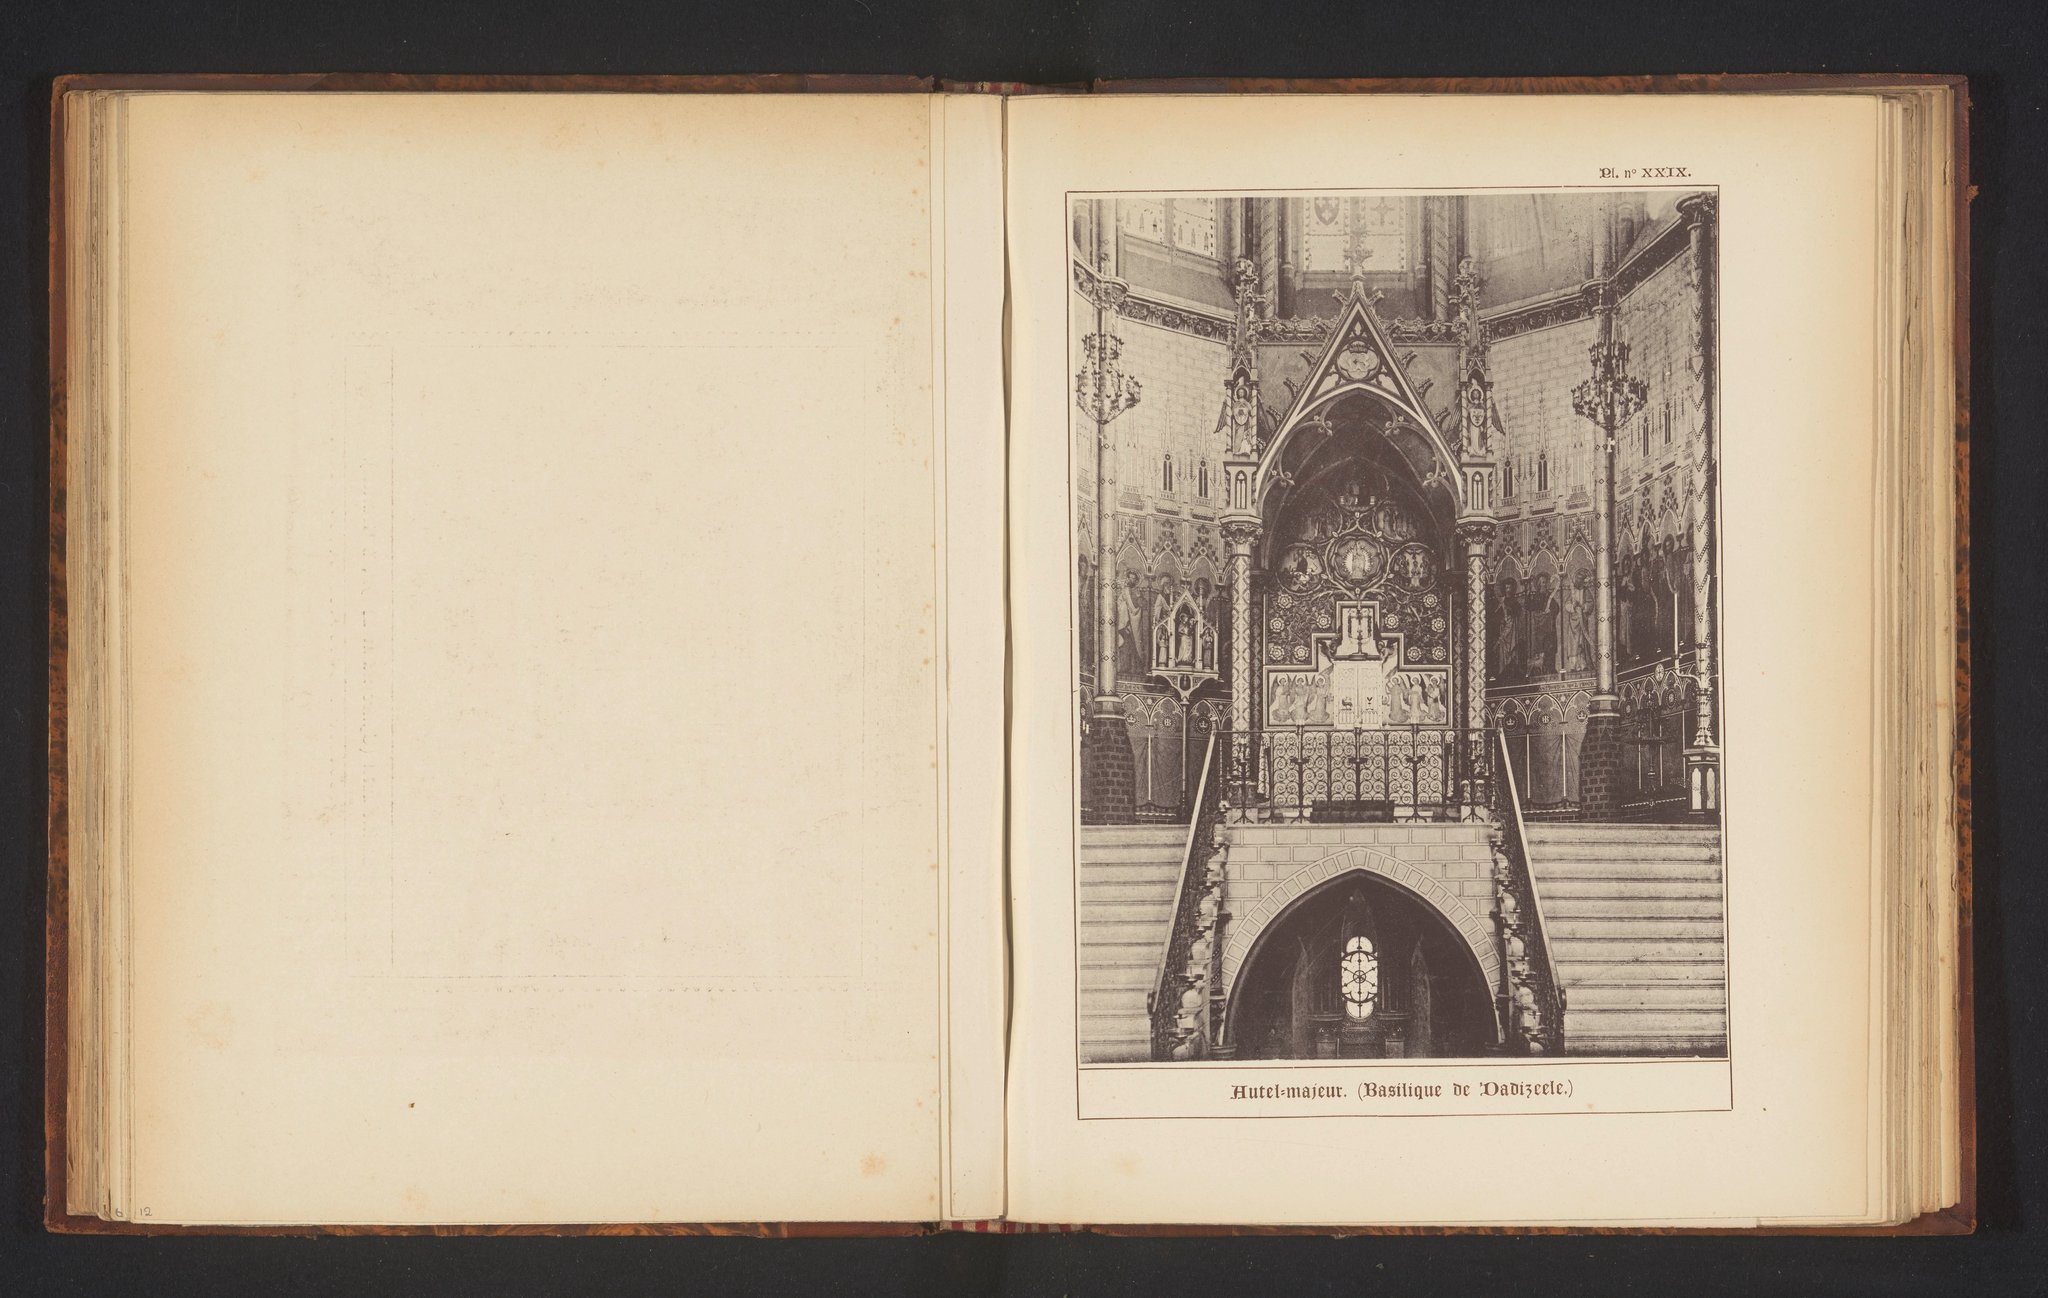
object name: page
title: Groot altaar in de Basiliek van Onze-Lieve-Vrouw van Dadizele, België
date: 1891-1896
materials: paper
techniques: photograph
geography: dadizele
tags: altar with altar-piece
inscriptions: number: ‘Pl. no XXIX.’